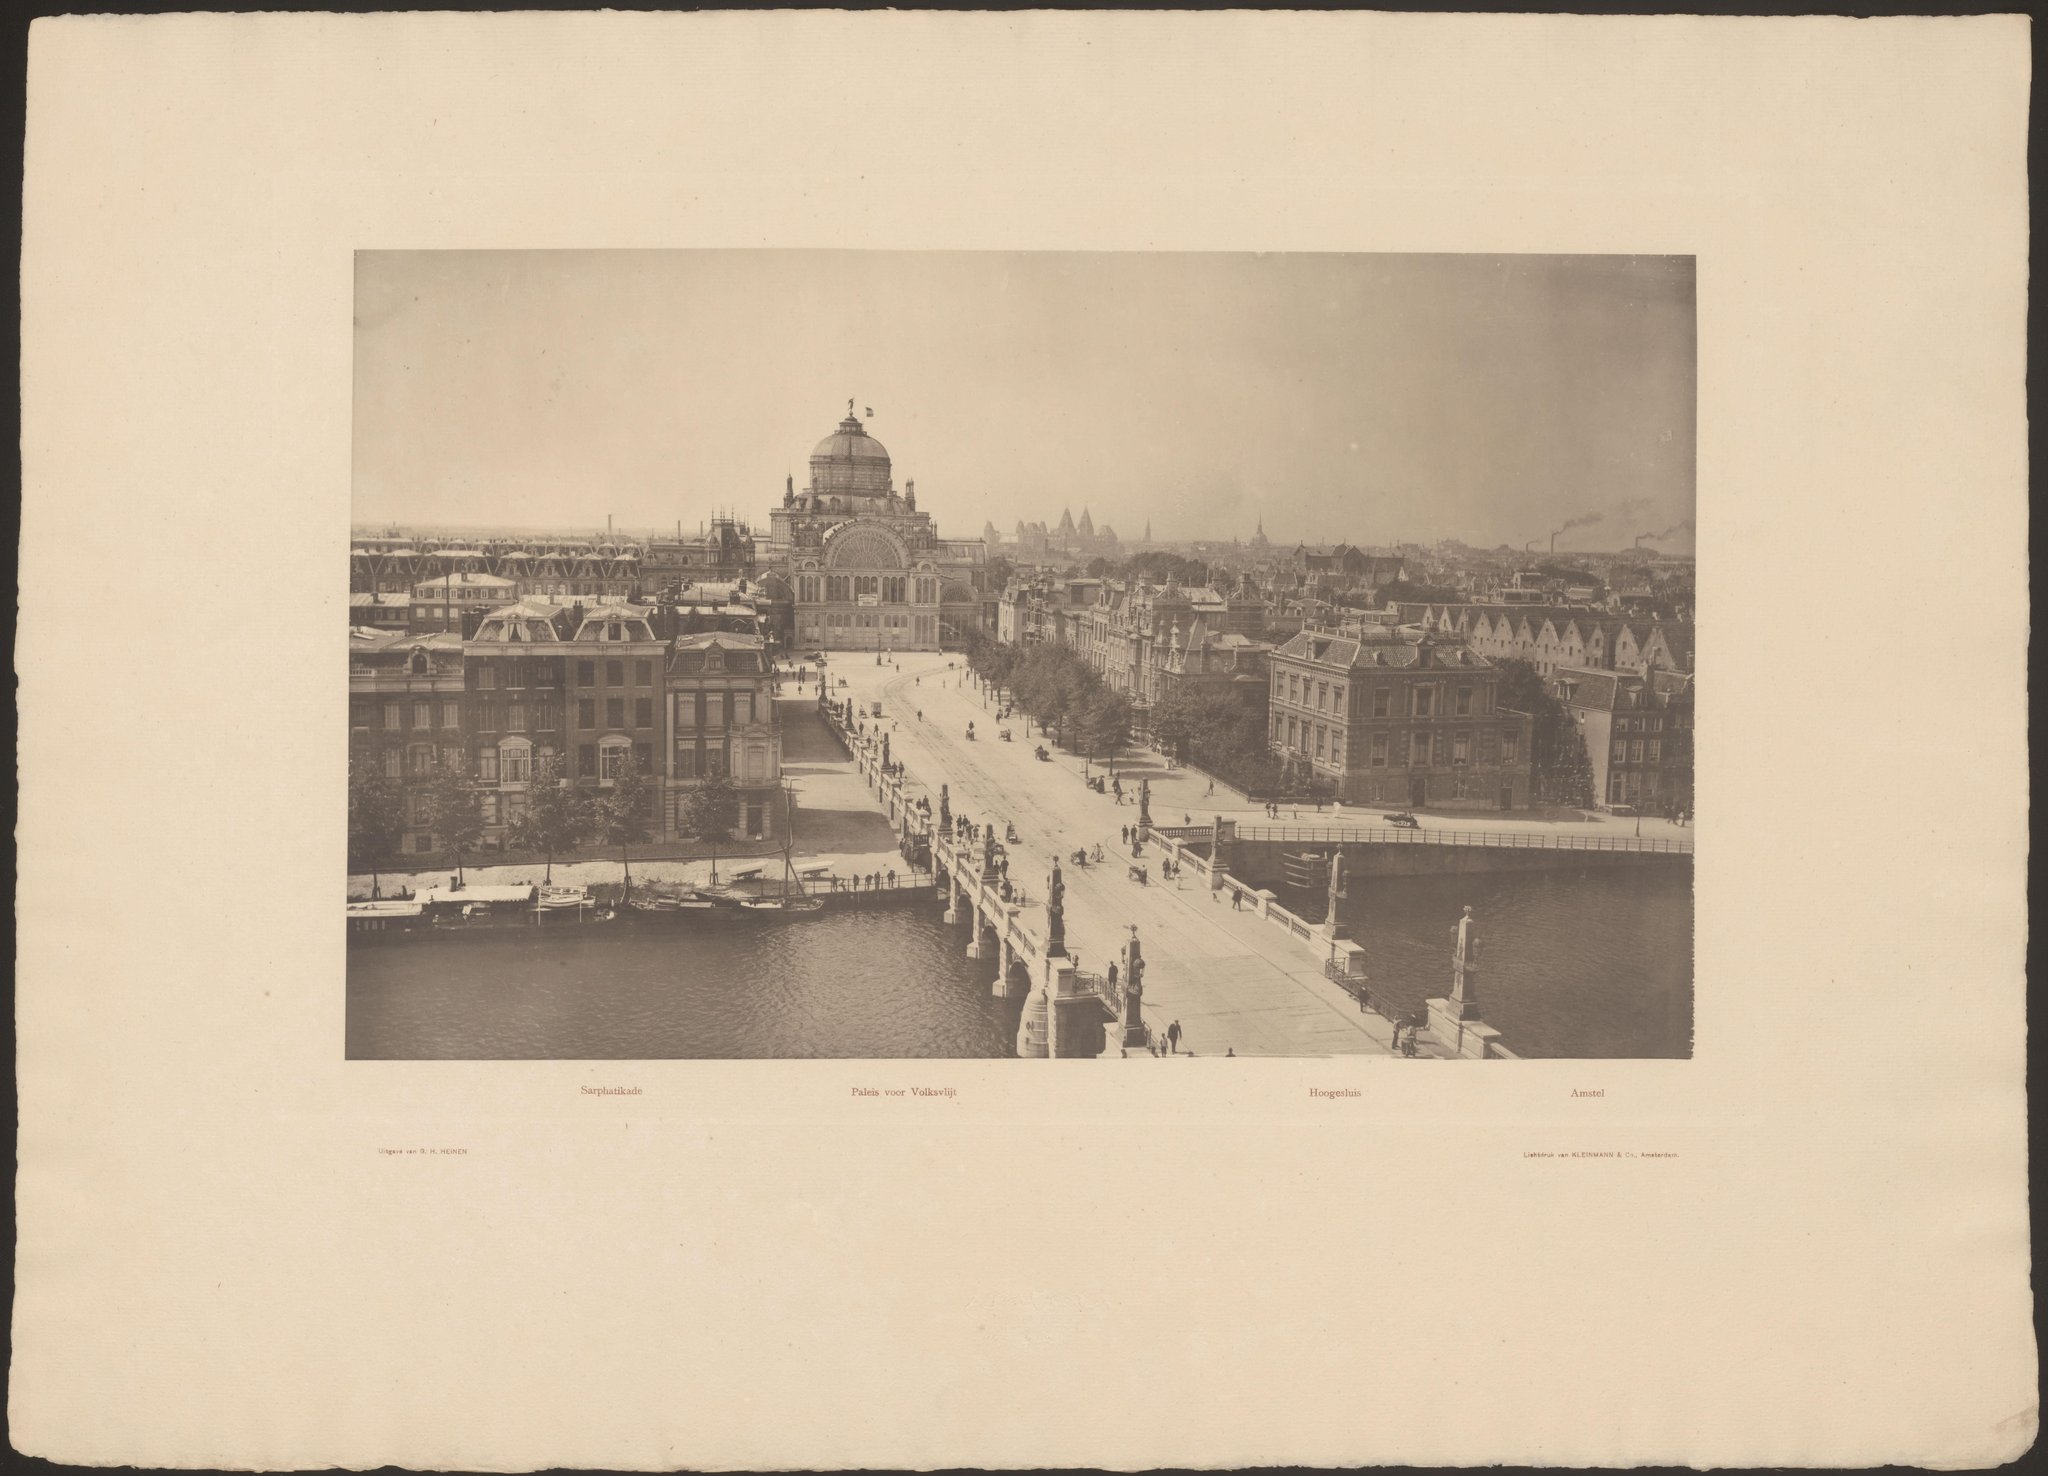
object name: photomechanical print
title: Gezicht op de Hogesluis en het Paleis voor Volksvlijt vanuit het Amstel Hotel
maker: gerrit hendricus heinen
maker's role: painter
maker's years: 1851-1930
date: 1892-1930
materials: paper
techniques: photograph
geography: amsterdam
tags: river, gallery (spacious corridor), permanent exhibition, museum, bridge in city across river, canal, etc., street, prospect of city, town panorama, silhouette of city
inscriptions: check stamp: ‘G.H. Heinen Amsterdam / Schilder & Fotograaf’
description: Onderwerpsrubriek binnen de Atlas Amsterdam: Panorama's en verzamelprenten.